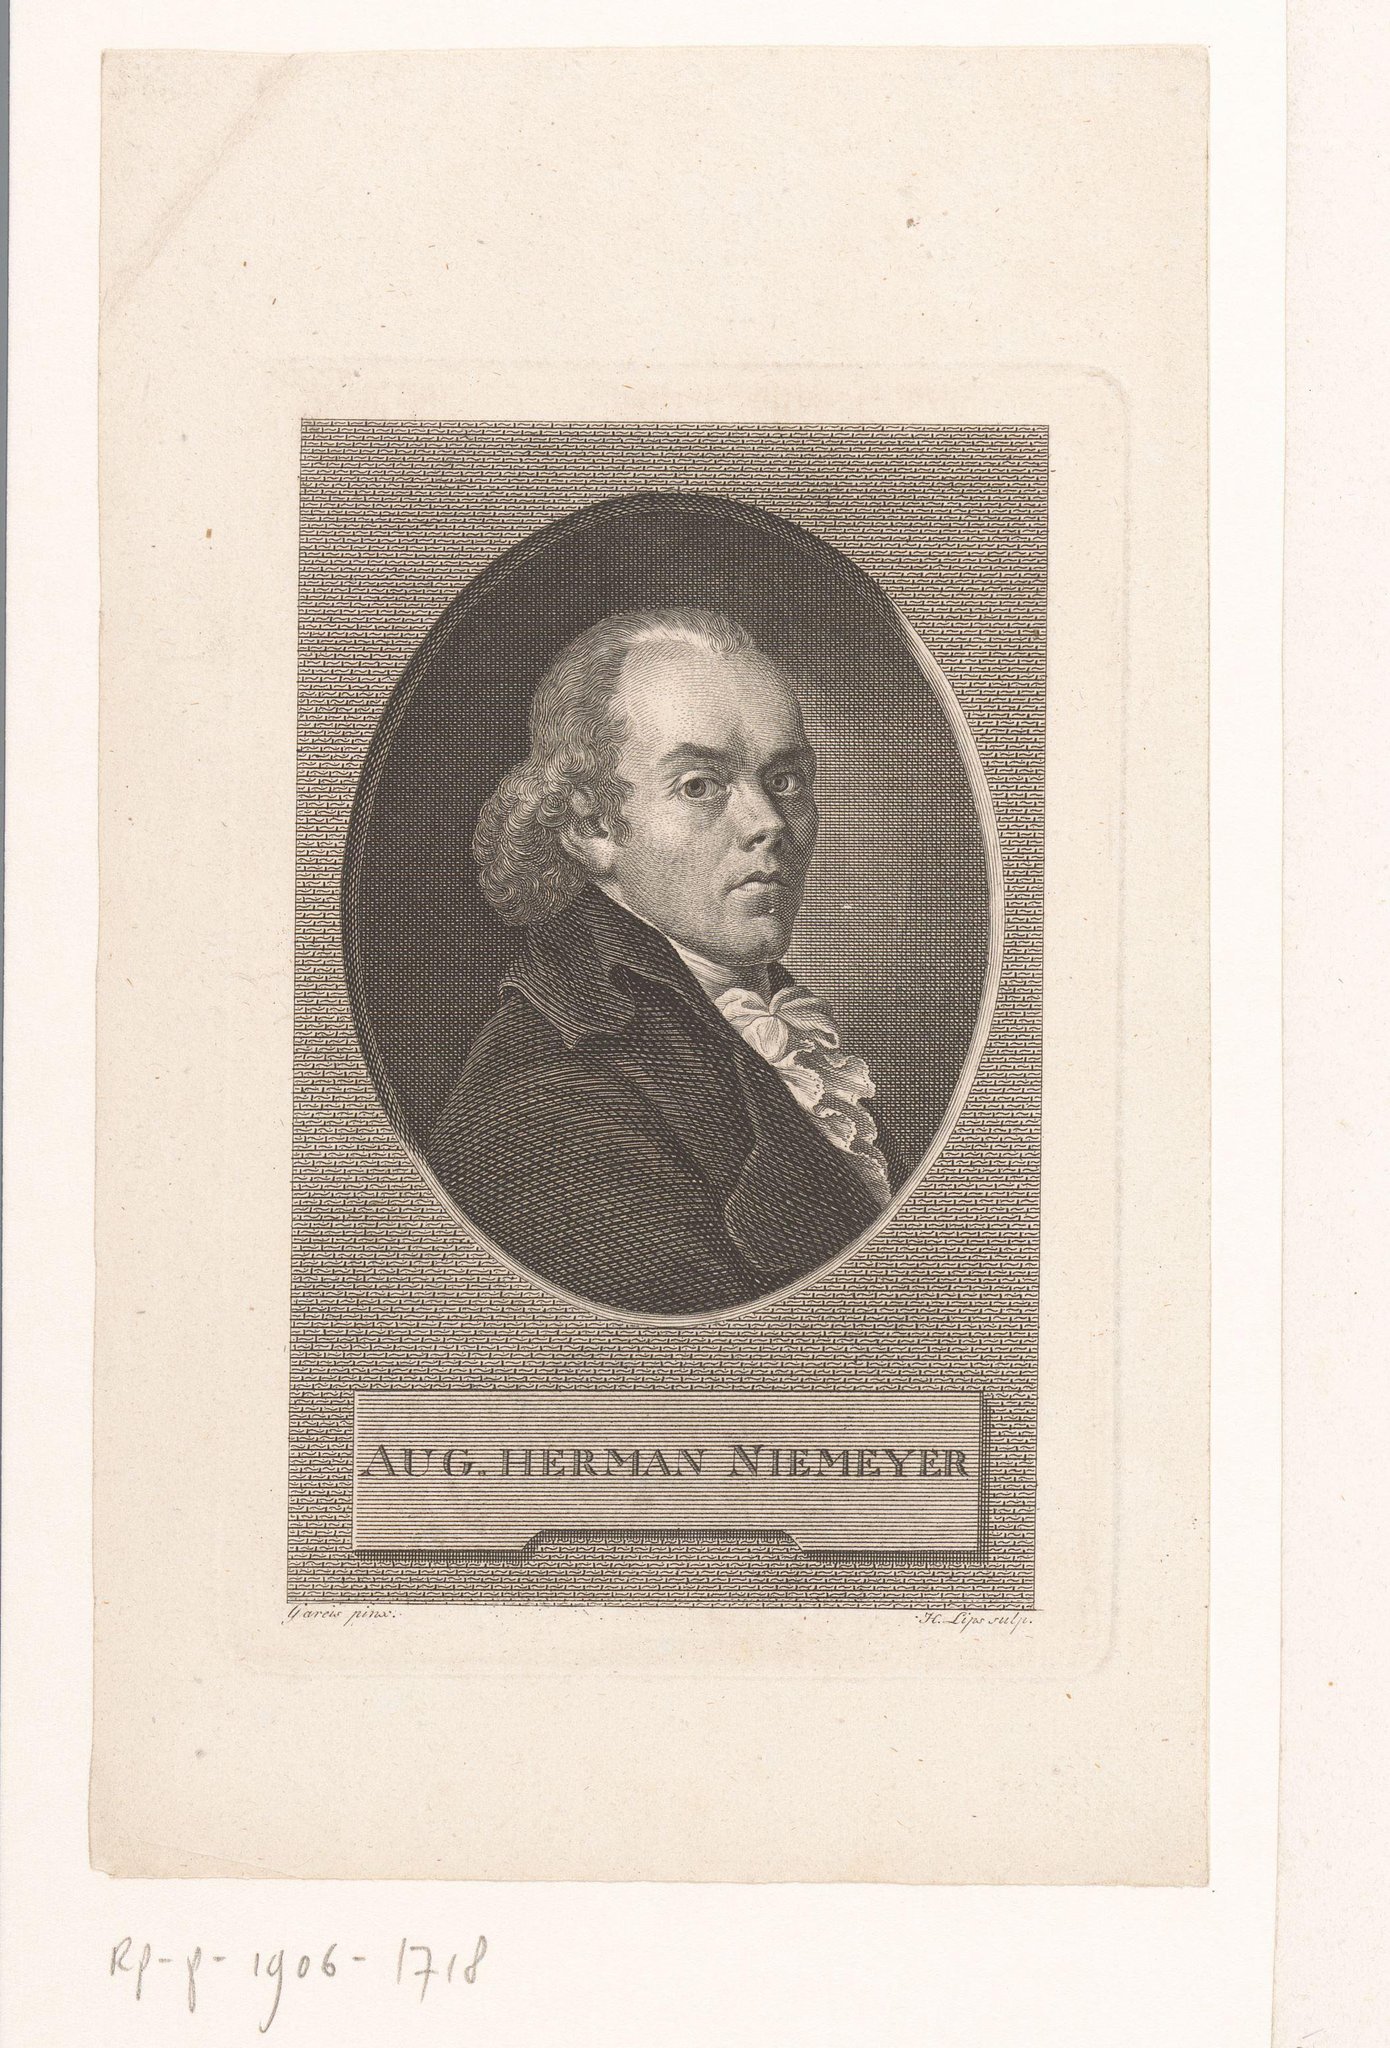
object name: print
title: Portret van August Hermann Niemeyer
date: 1768-1817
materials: paper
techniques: engraving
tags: theologian, historical persons, portrait of a writer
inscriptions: collector's mark: Lugt 2228